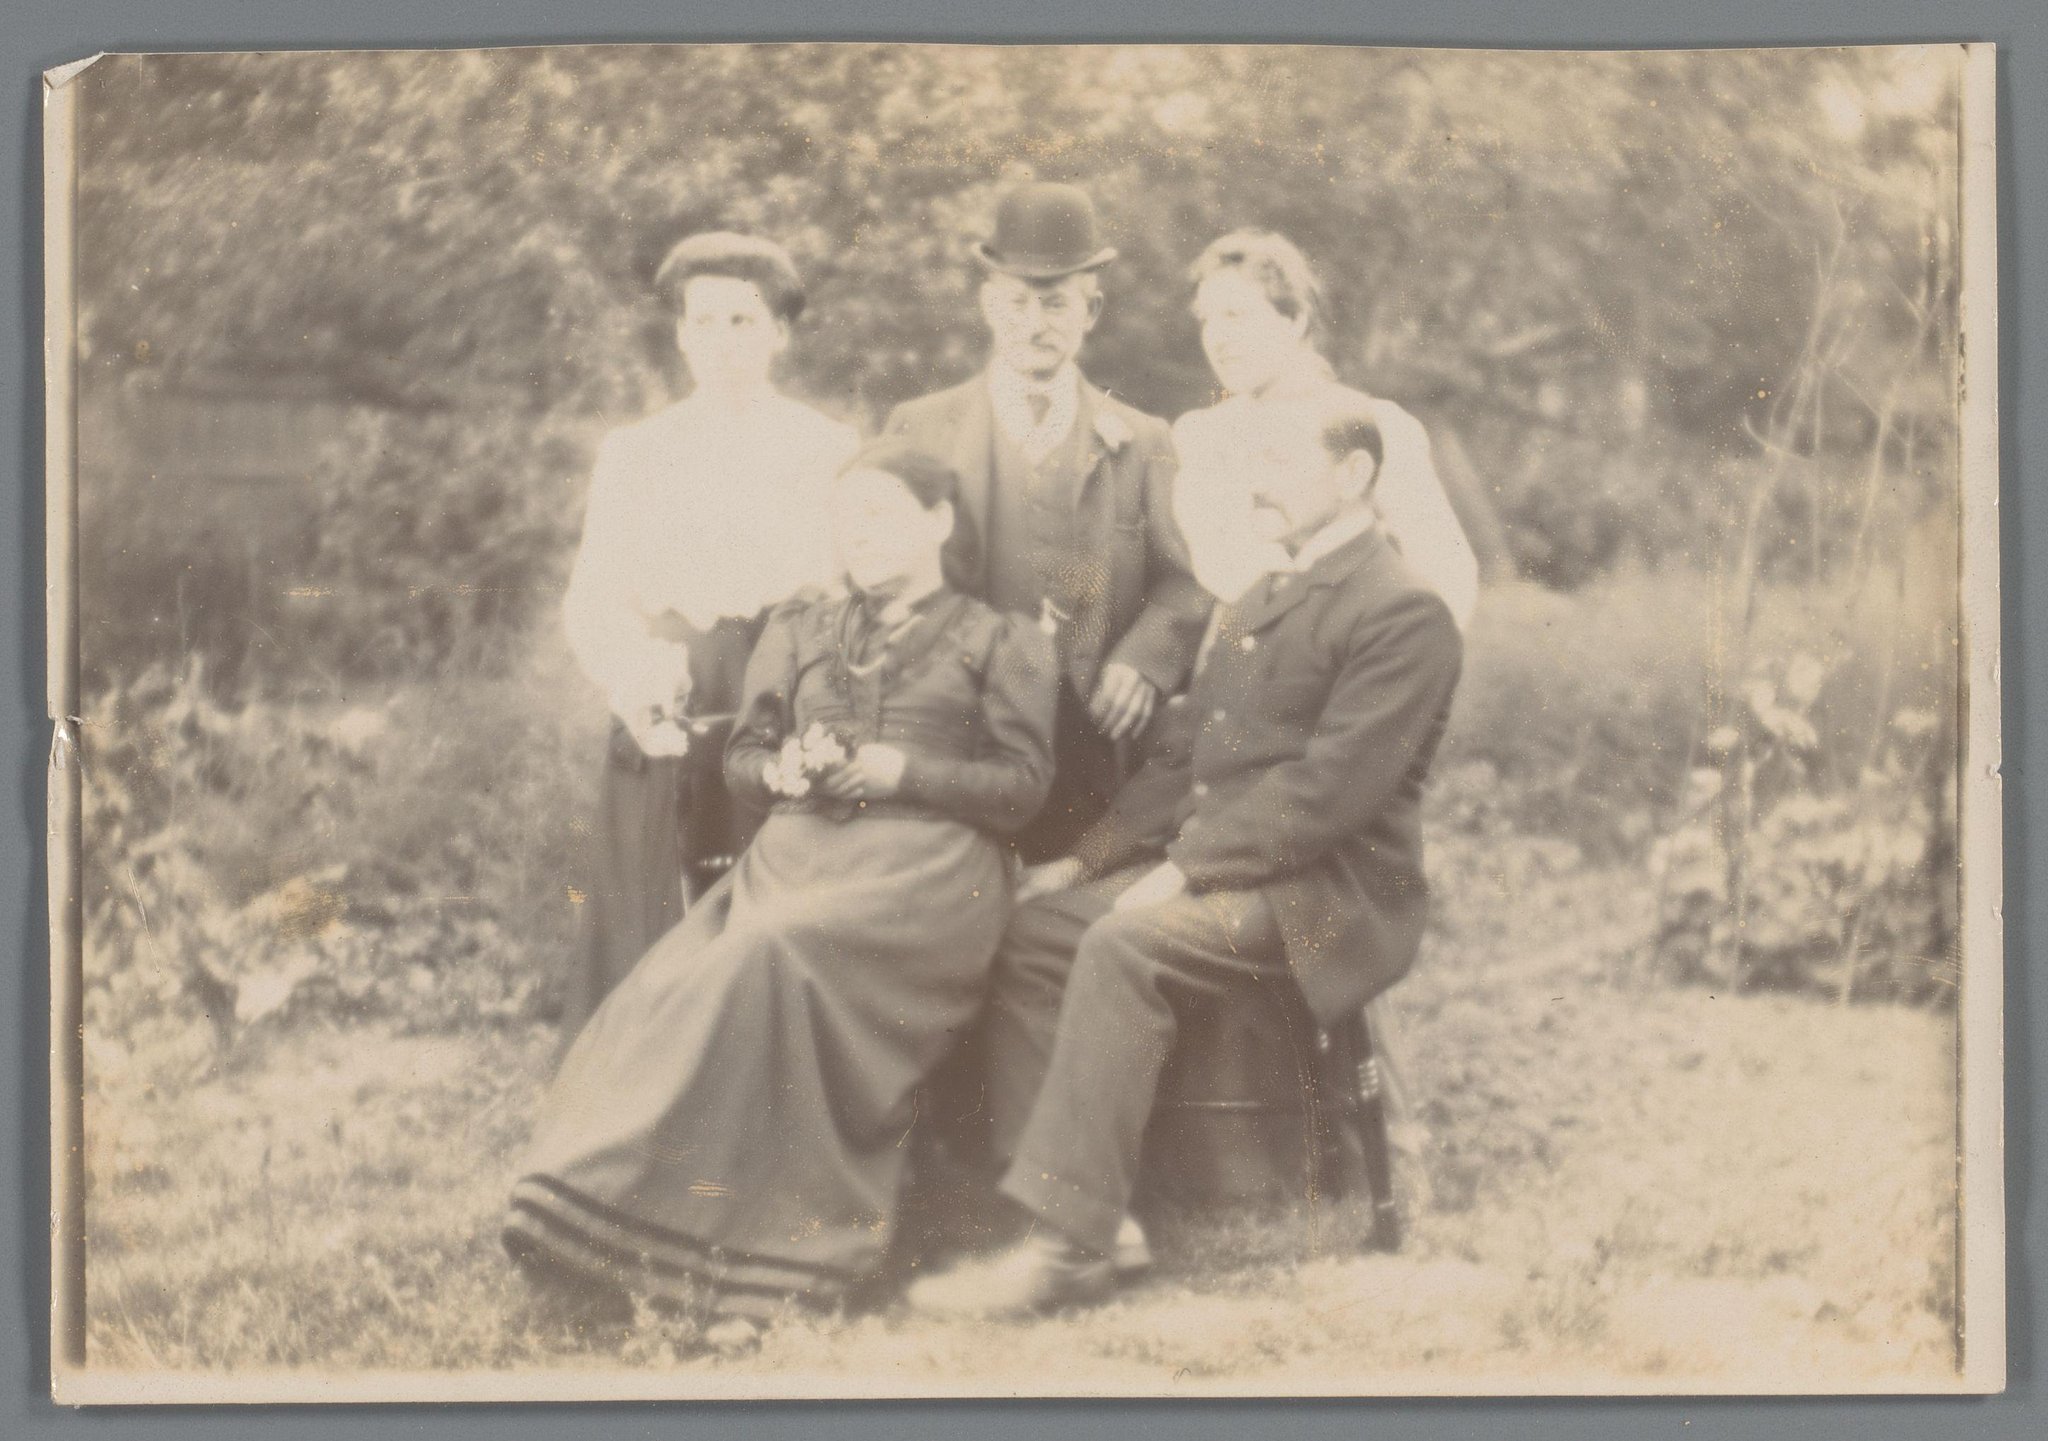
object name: photograph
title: Portret van twee onbekende mannen en drie onbekende vrouwen in een tuin of park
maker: Anonymous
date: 1882-1920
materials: photographic support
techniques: gelatin silver print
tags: adult man (+ two persons), historical persons, adult woman (+ three persons)